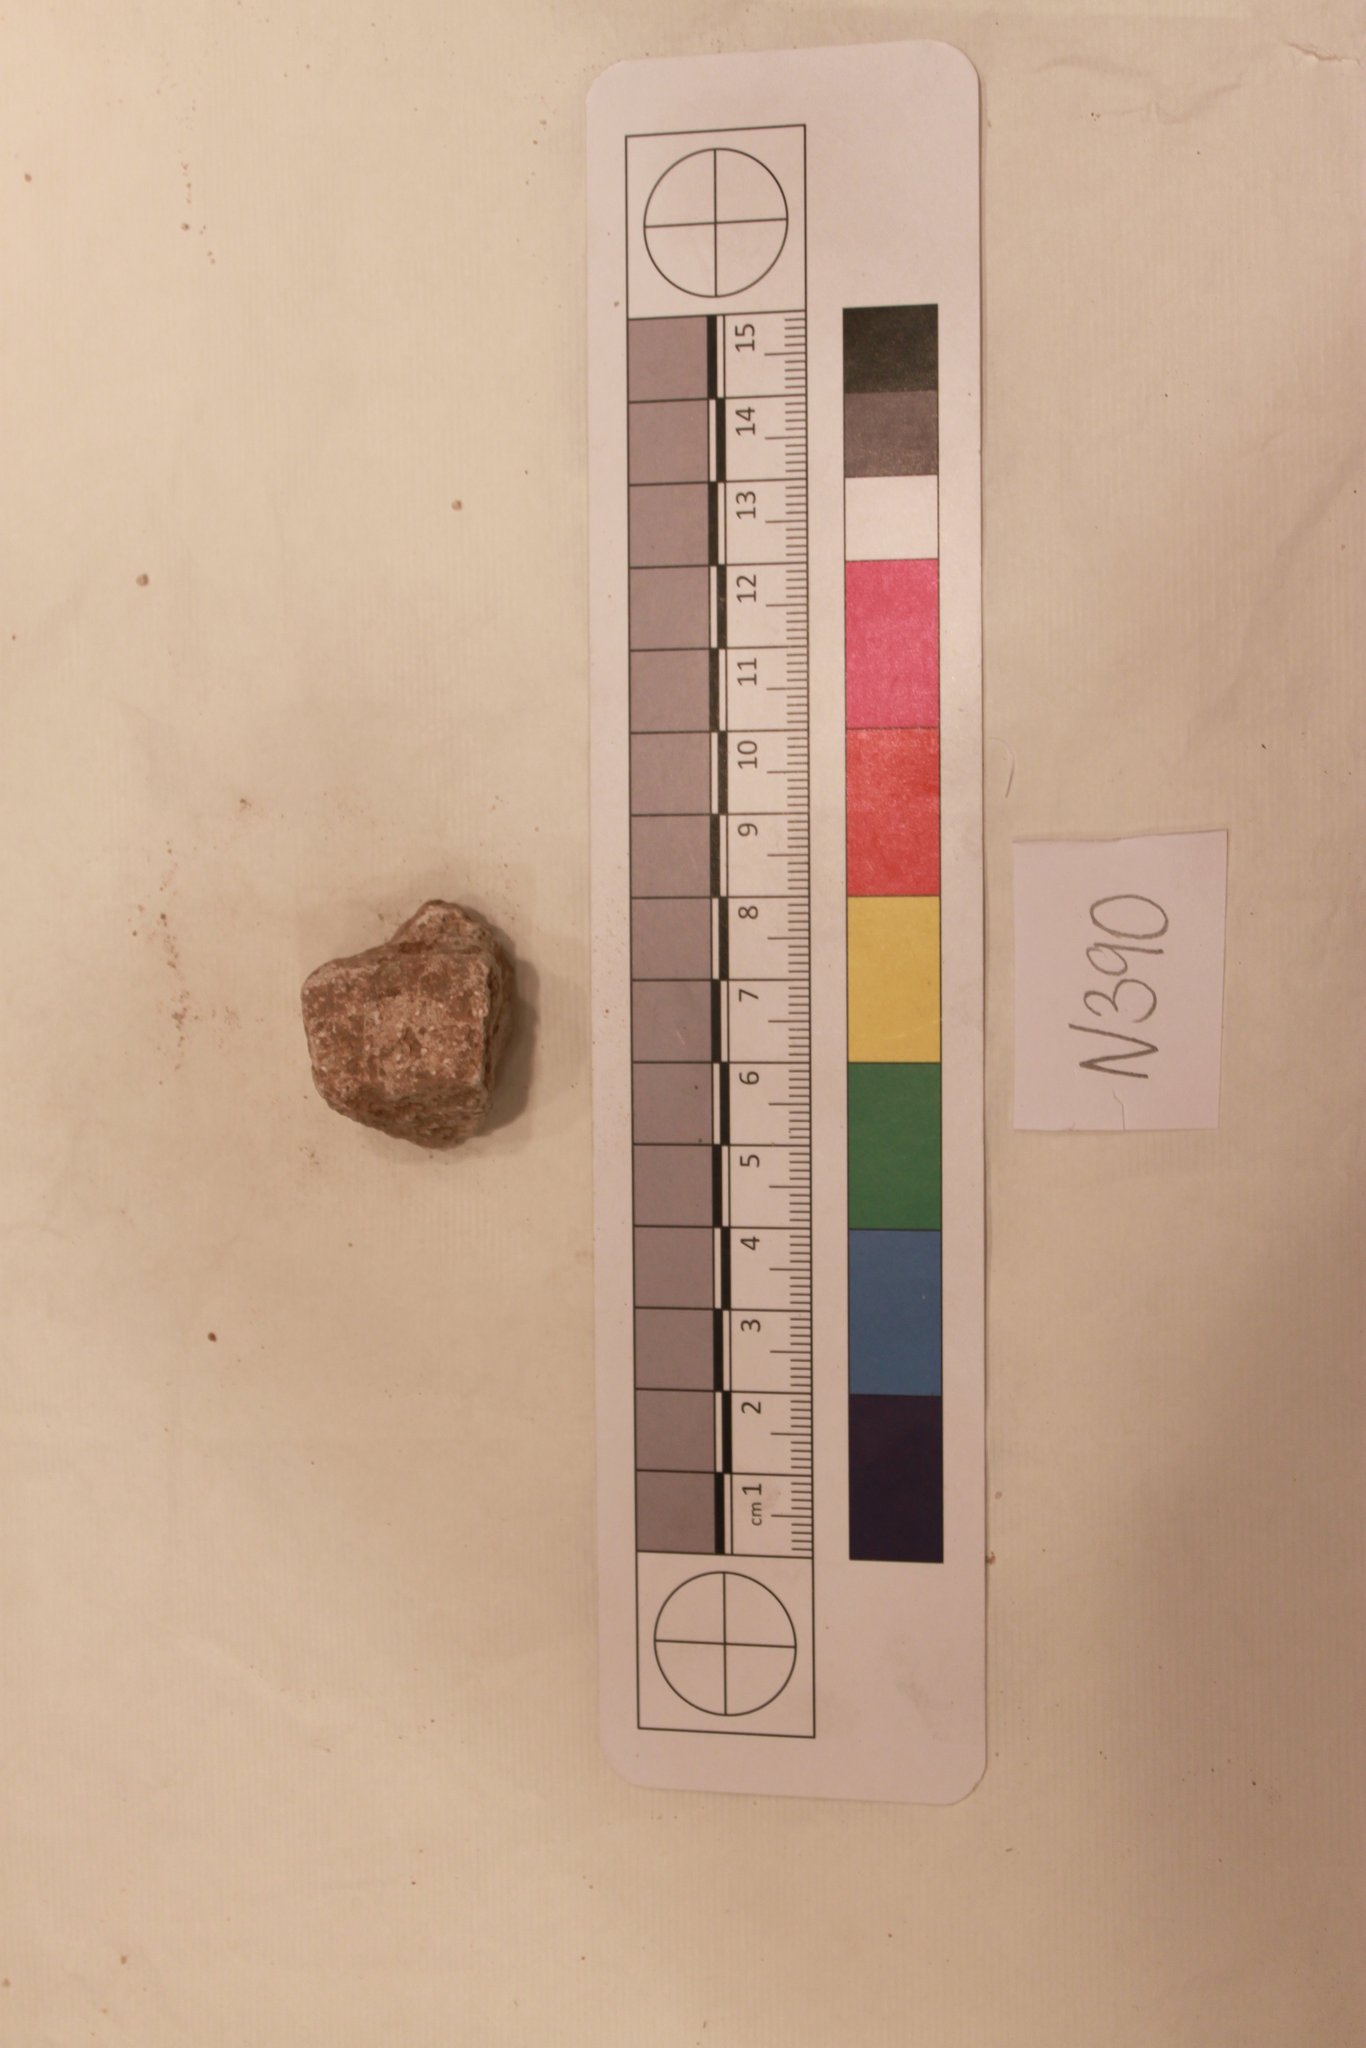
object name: fragment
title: Stucco Fragment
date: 701-1200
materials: plaster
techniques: carving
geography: iran